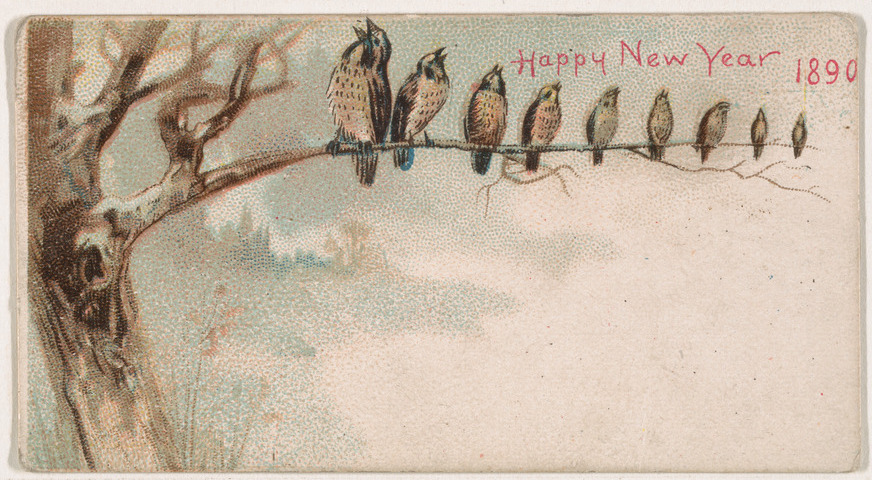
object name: print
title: Happy New Year 1890, from the New Years 1890 series (N227) issued by Kinney Bros.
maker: kinney brothers tobacco company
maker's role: publisher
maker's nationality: american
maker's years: 1869-2011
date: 1889-1890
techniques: color lithograph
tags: birds